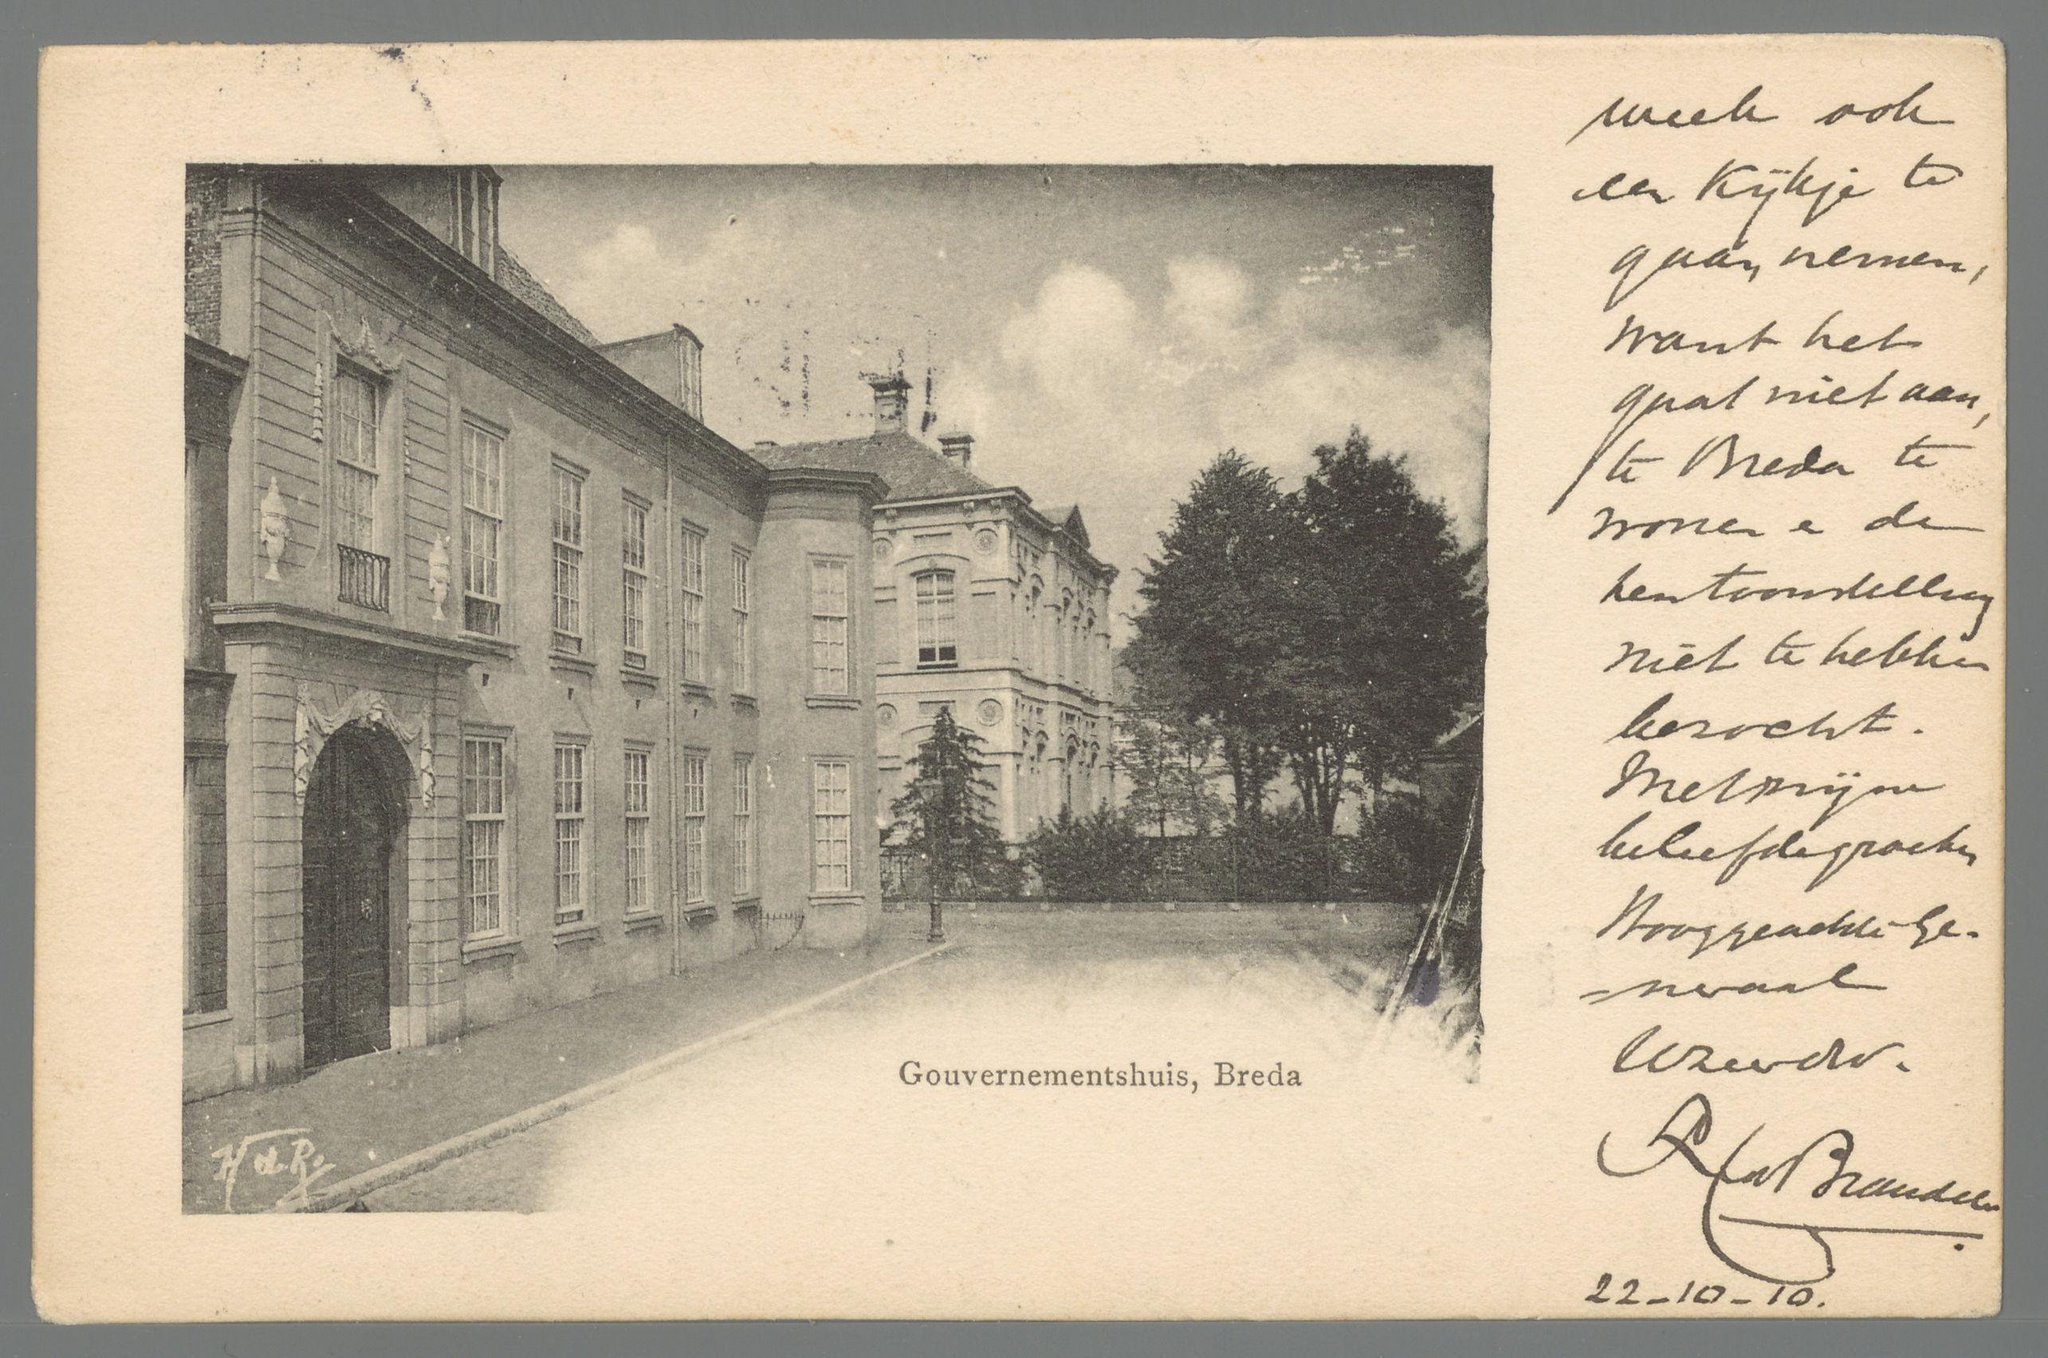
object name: ansichtkaart, prentbriefkaart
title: Gouvernementshuis, Breda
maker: Anonymous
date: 1905-1910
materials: cardboard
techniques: photograph, writing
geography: breda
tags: city-view, and landscape with man-made constructions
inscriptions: postage stamp, monogram: ‘HdR’